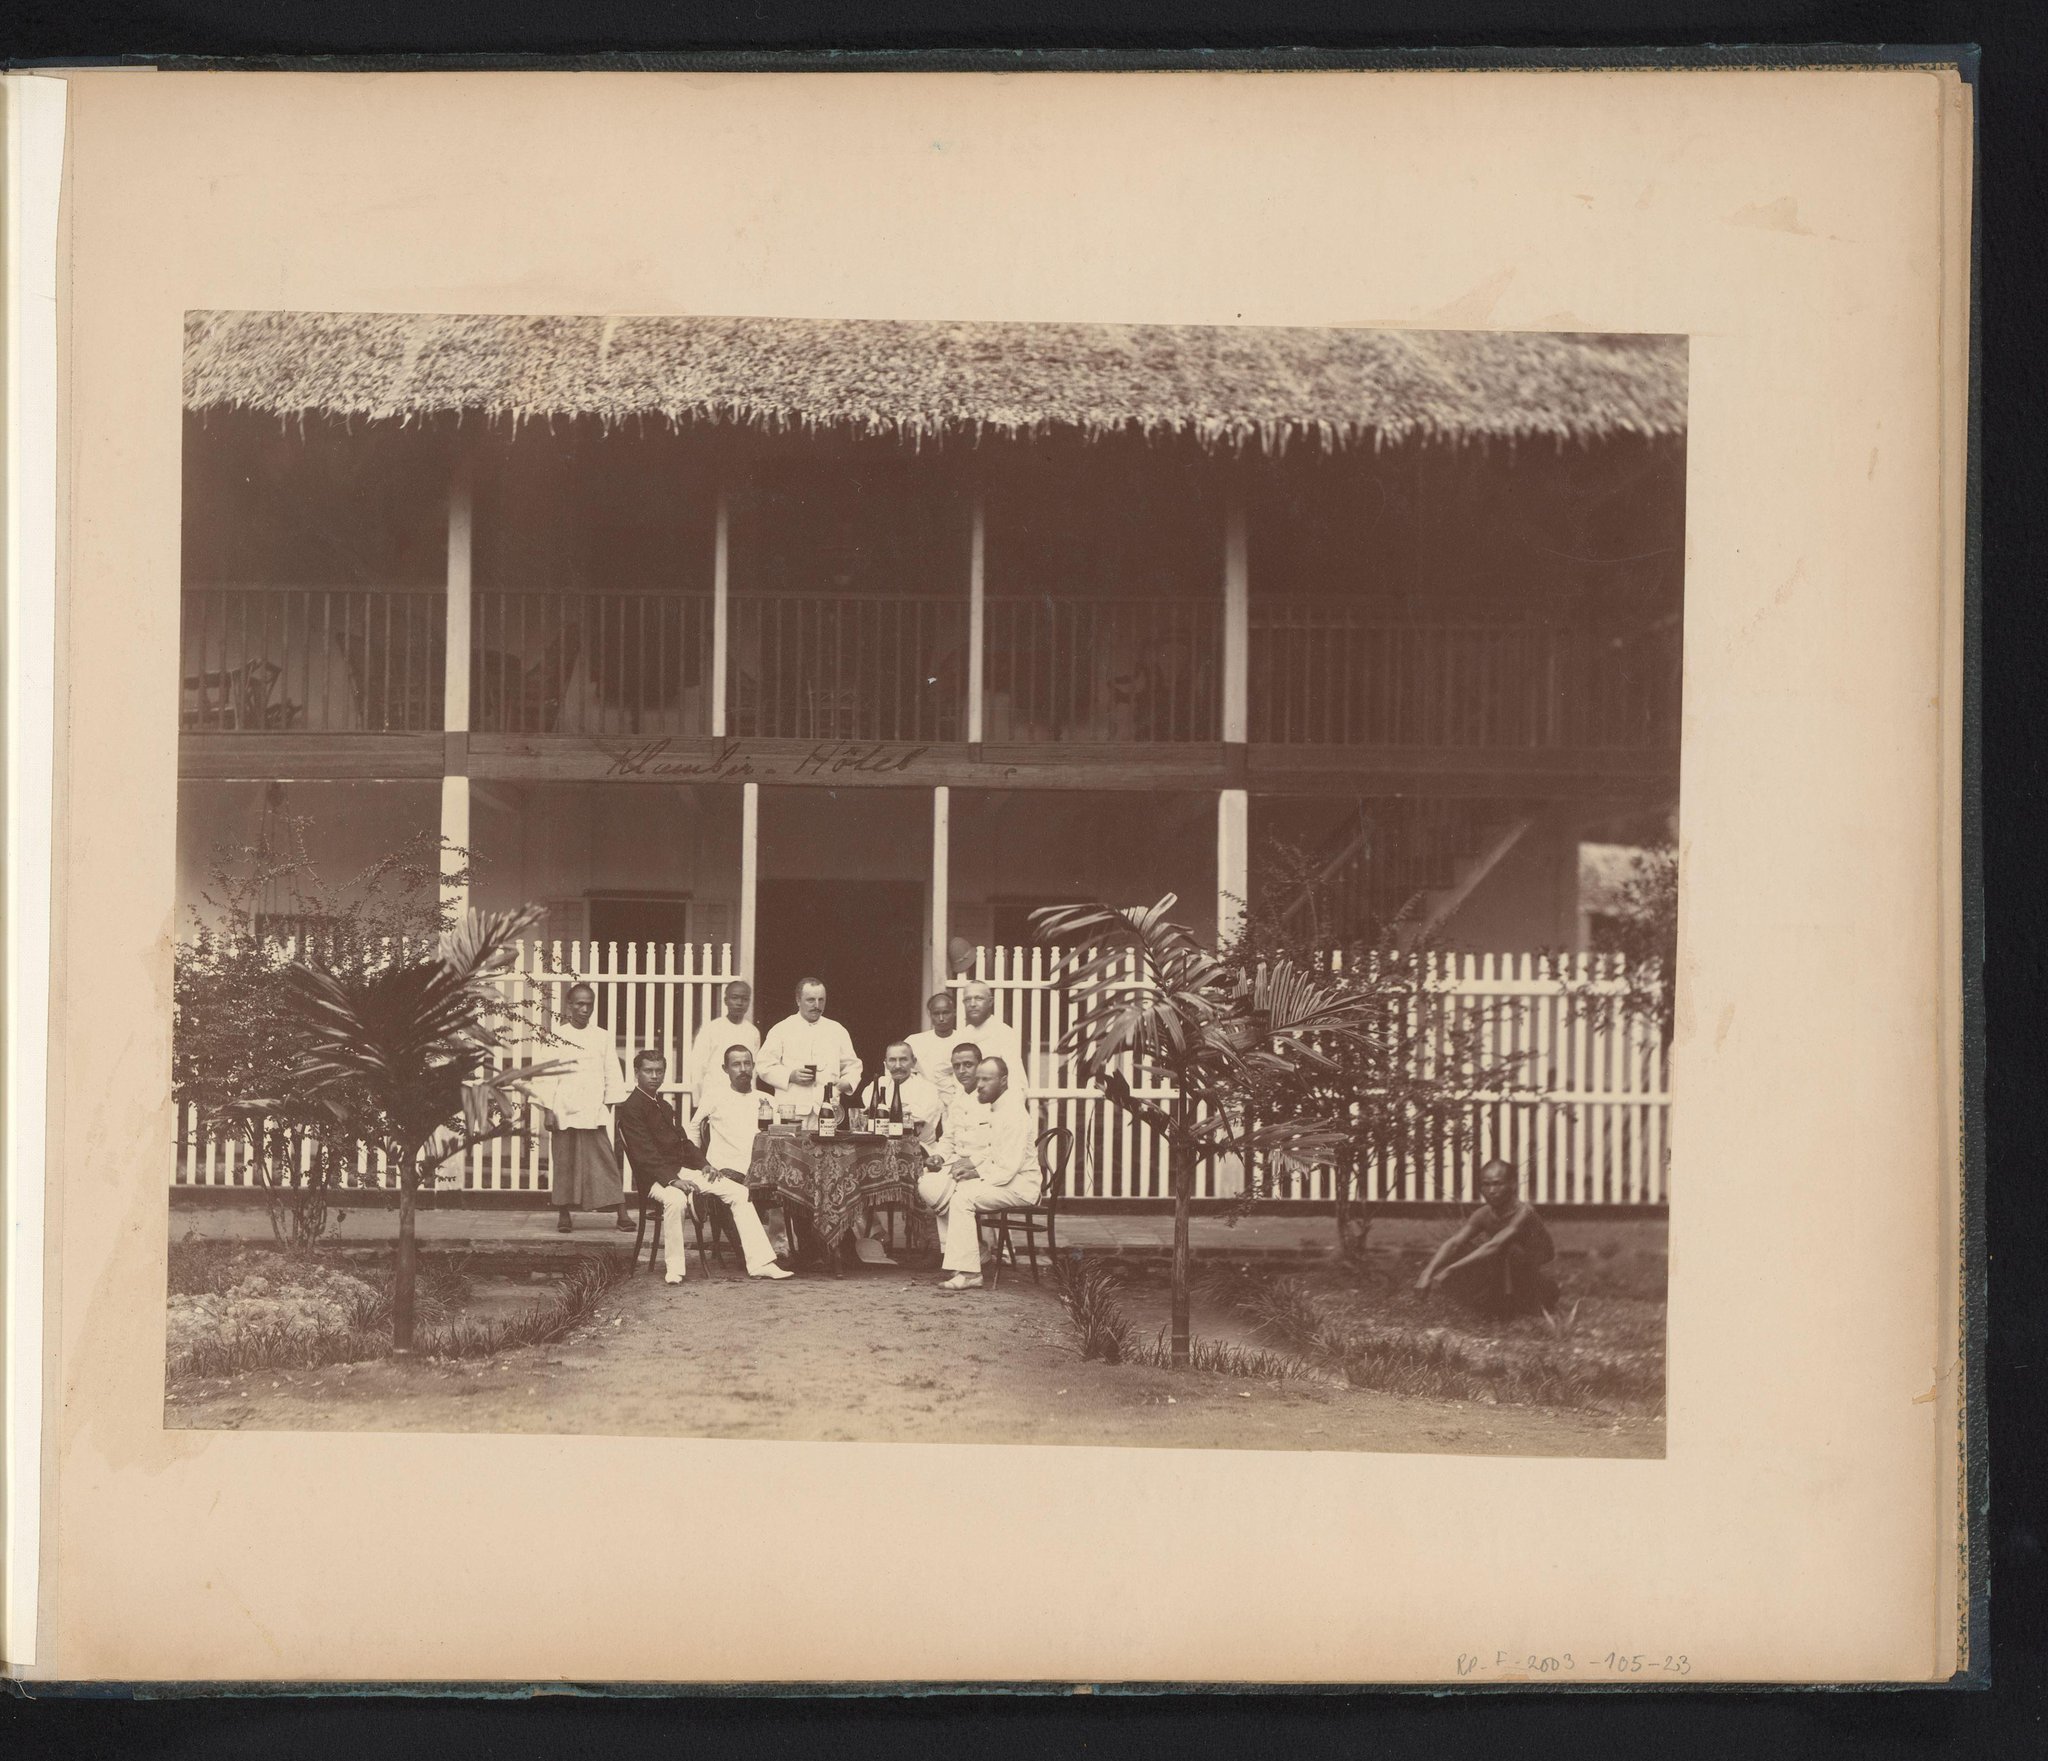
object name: photograph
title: Europese planters, onder wie Paul Sandel, met bedienden voor een hotel, vermoedelijk in Langkat, Sumatra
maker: Anonymous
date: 1890-1900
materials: cardboard, photographic support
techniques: albumen print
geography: sumatra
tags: paul sandel, plantation, hotel, hostelry, inn, house personnel, servants, sumatra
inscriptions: annotation: ‘Klambir Hôtel’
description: Europese mannen, waarschijnlijk leidinggevenden op plantages, voor 'Klambir Hotel' met bedienden. Deze foto is vermoedelijk in Langkat, Sumatra genomen, onder hen plantage-eigenaar Paul Sandel.